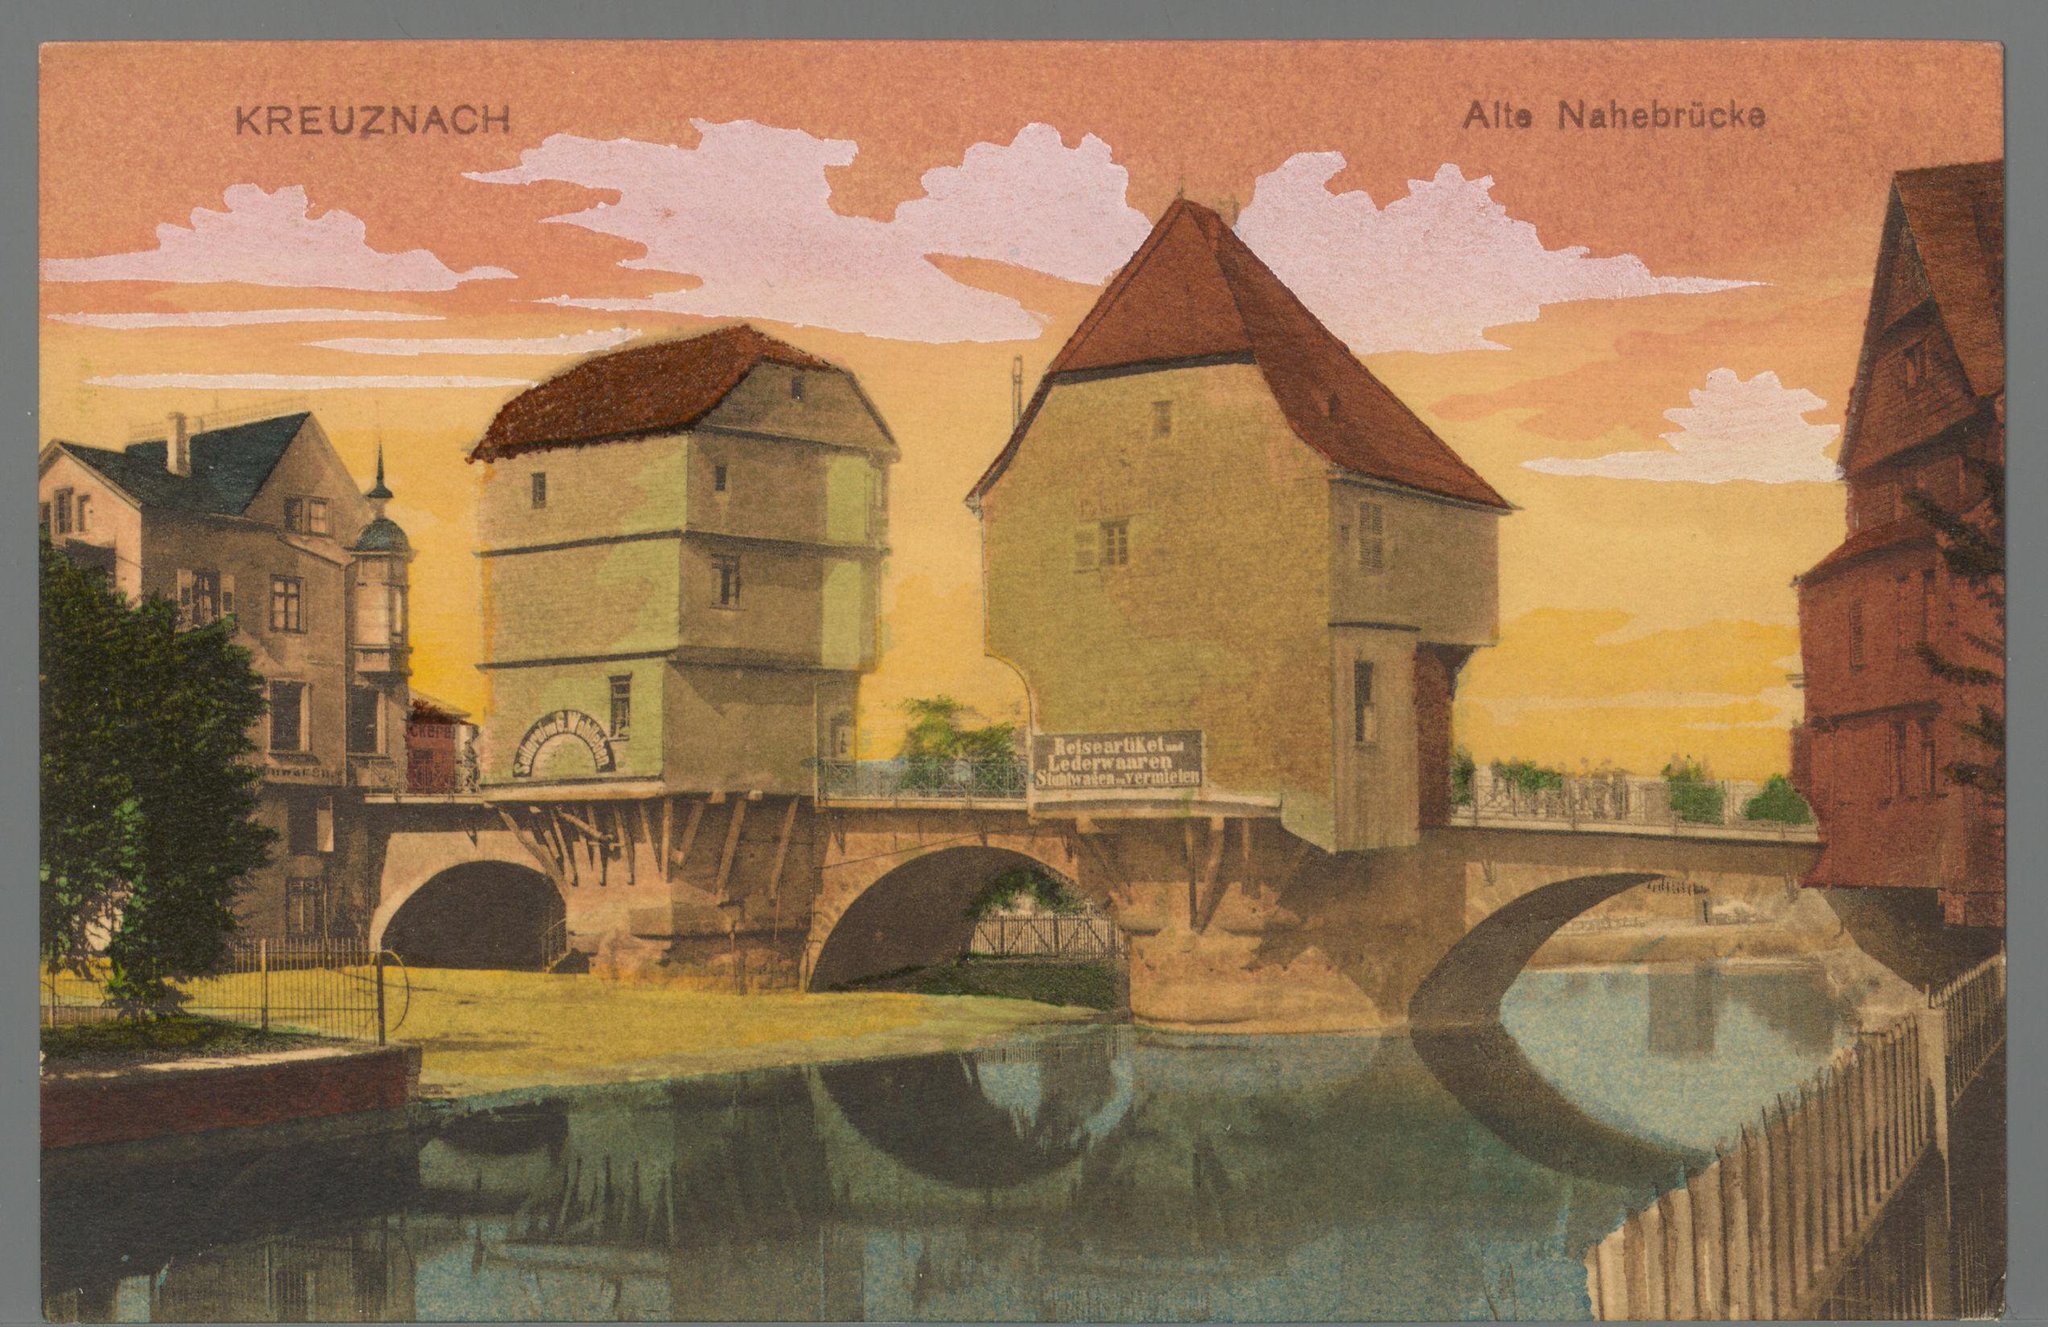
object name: photomechanical print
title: Kreuznach. Alte Nahebrücke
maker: Anonymous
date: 1906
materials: cardboard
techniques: photograph, lithograph, hand coloring, writing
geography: wiesbaden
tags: city-view, and landscape with man-made constructions, canals, waters (in city), bridge in city across river, canal, etc.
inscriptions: date